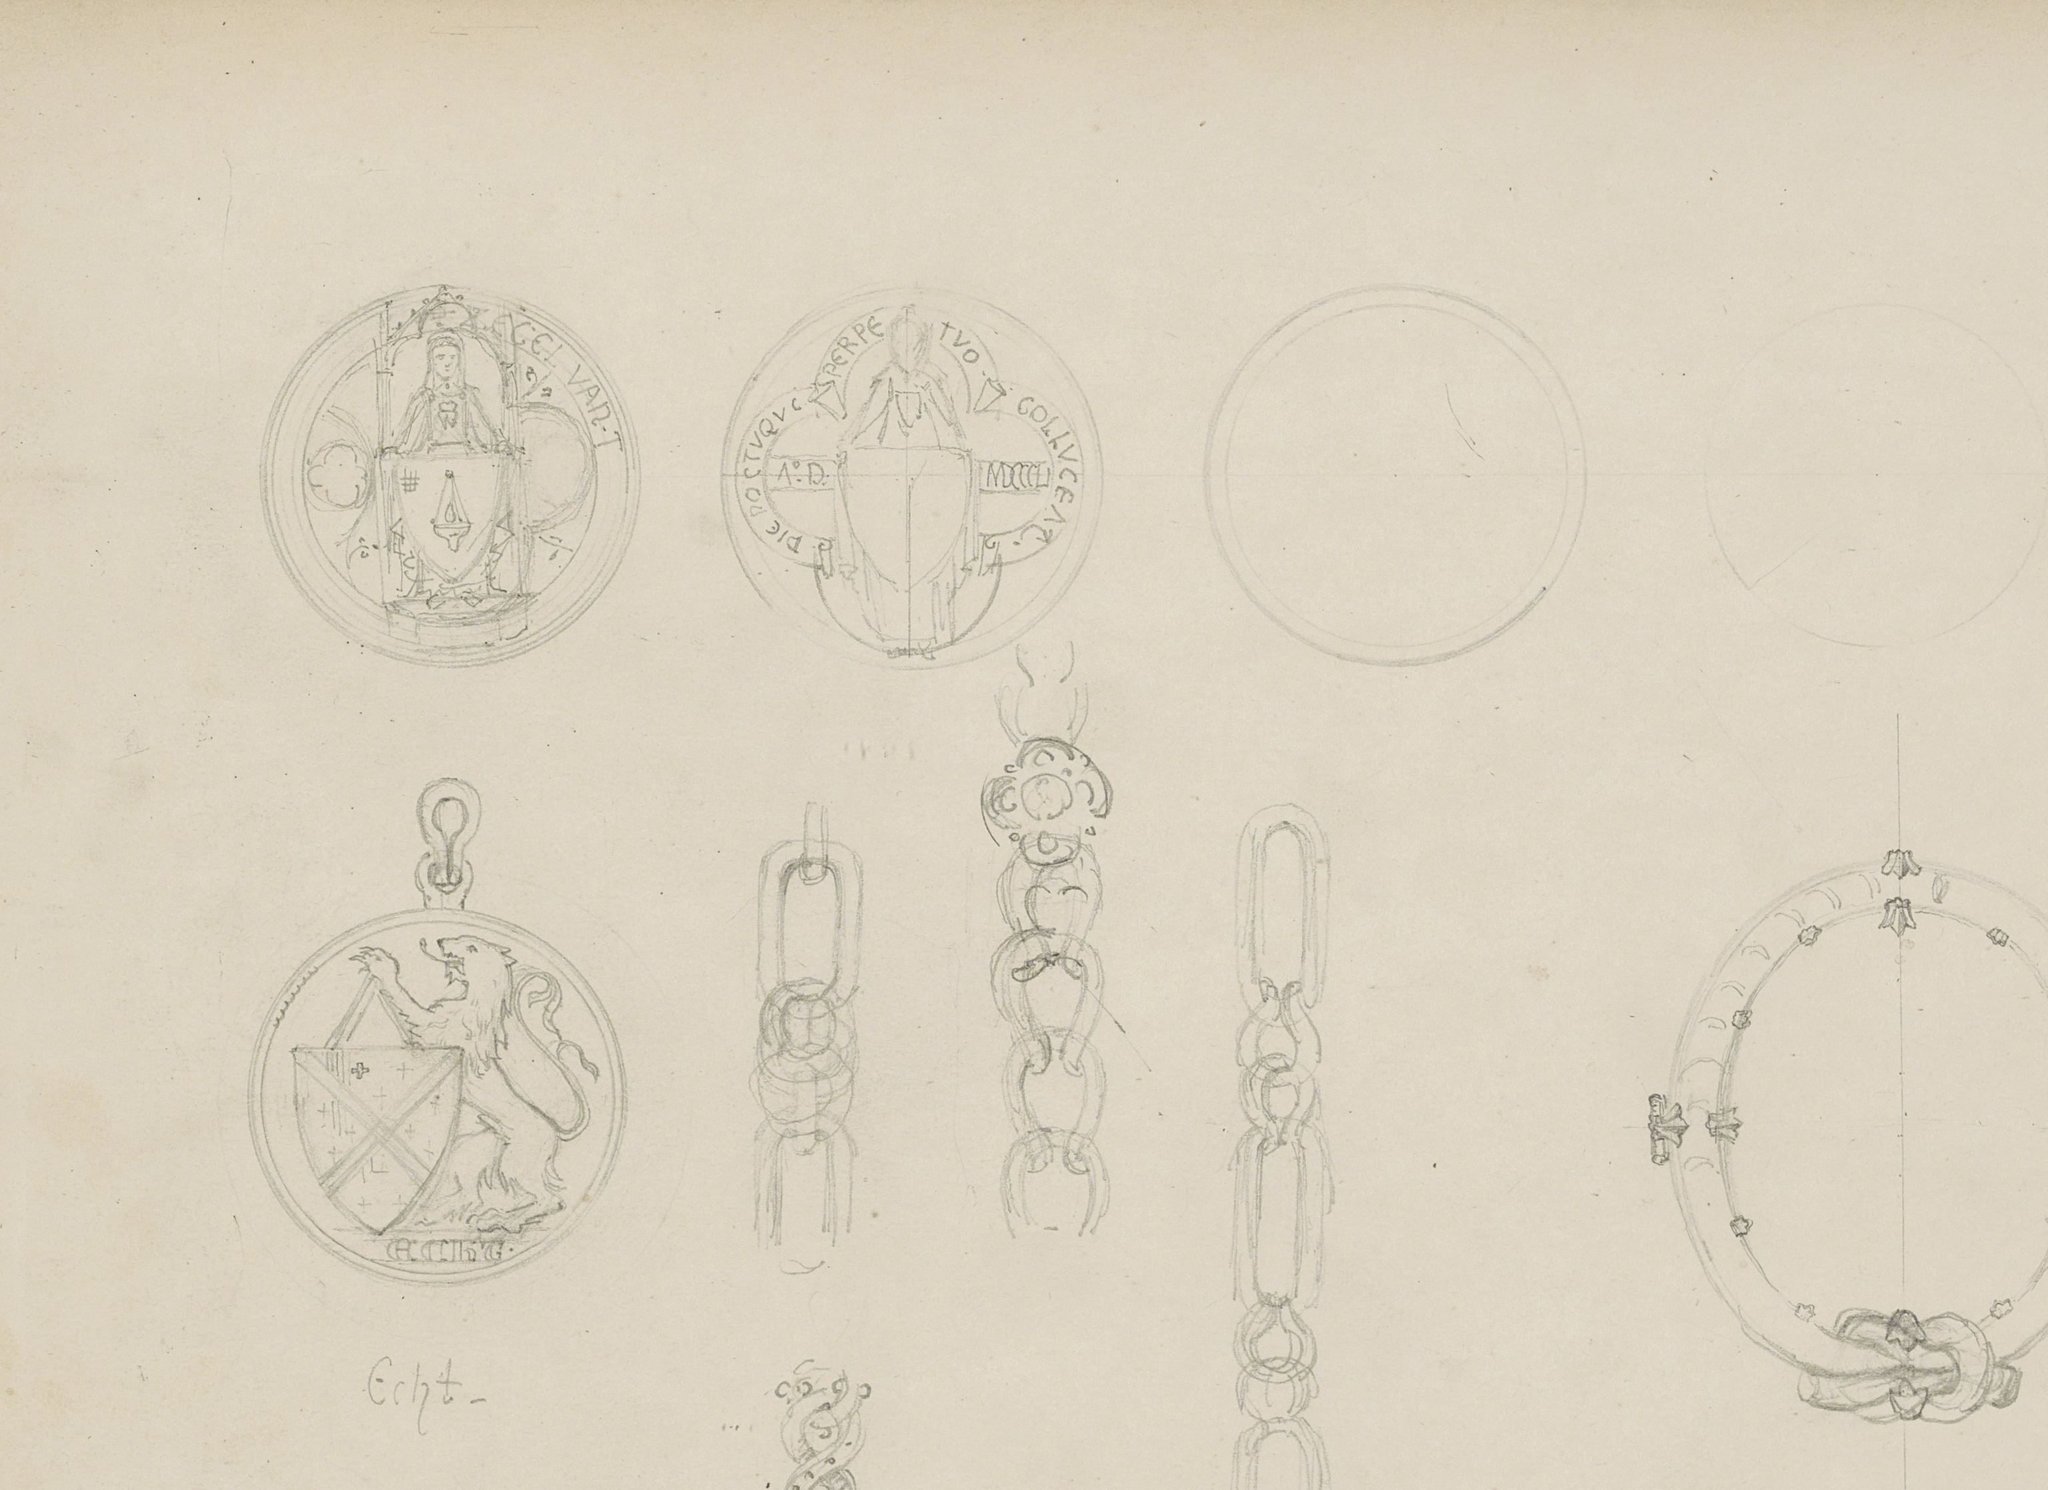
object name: sketchbook leaf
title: Studieblad, onder andere met armbanden en het gemeentewapen van Echt in een medaillon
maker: pierre joseph hubert cuypers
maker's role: draughtsman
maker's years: 1827-1921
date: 1857-1859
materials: paper, pencil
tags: coat of arms (as symbol of the state, etc.) (+ city; municipal), bracelet, wristlet, pendant, trinket, 'breloque'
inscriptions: annotation: ‘Echt’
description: Het medaillon toont een leeuw die het gemeentewapen van Echt omhoog houdt. Tevens twee studies van bisschoppen in ronde omlijstingen. Mogelijk betreft het munten. Blad 31 recto uit een schetsboek met 77 bladen.